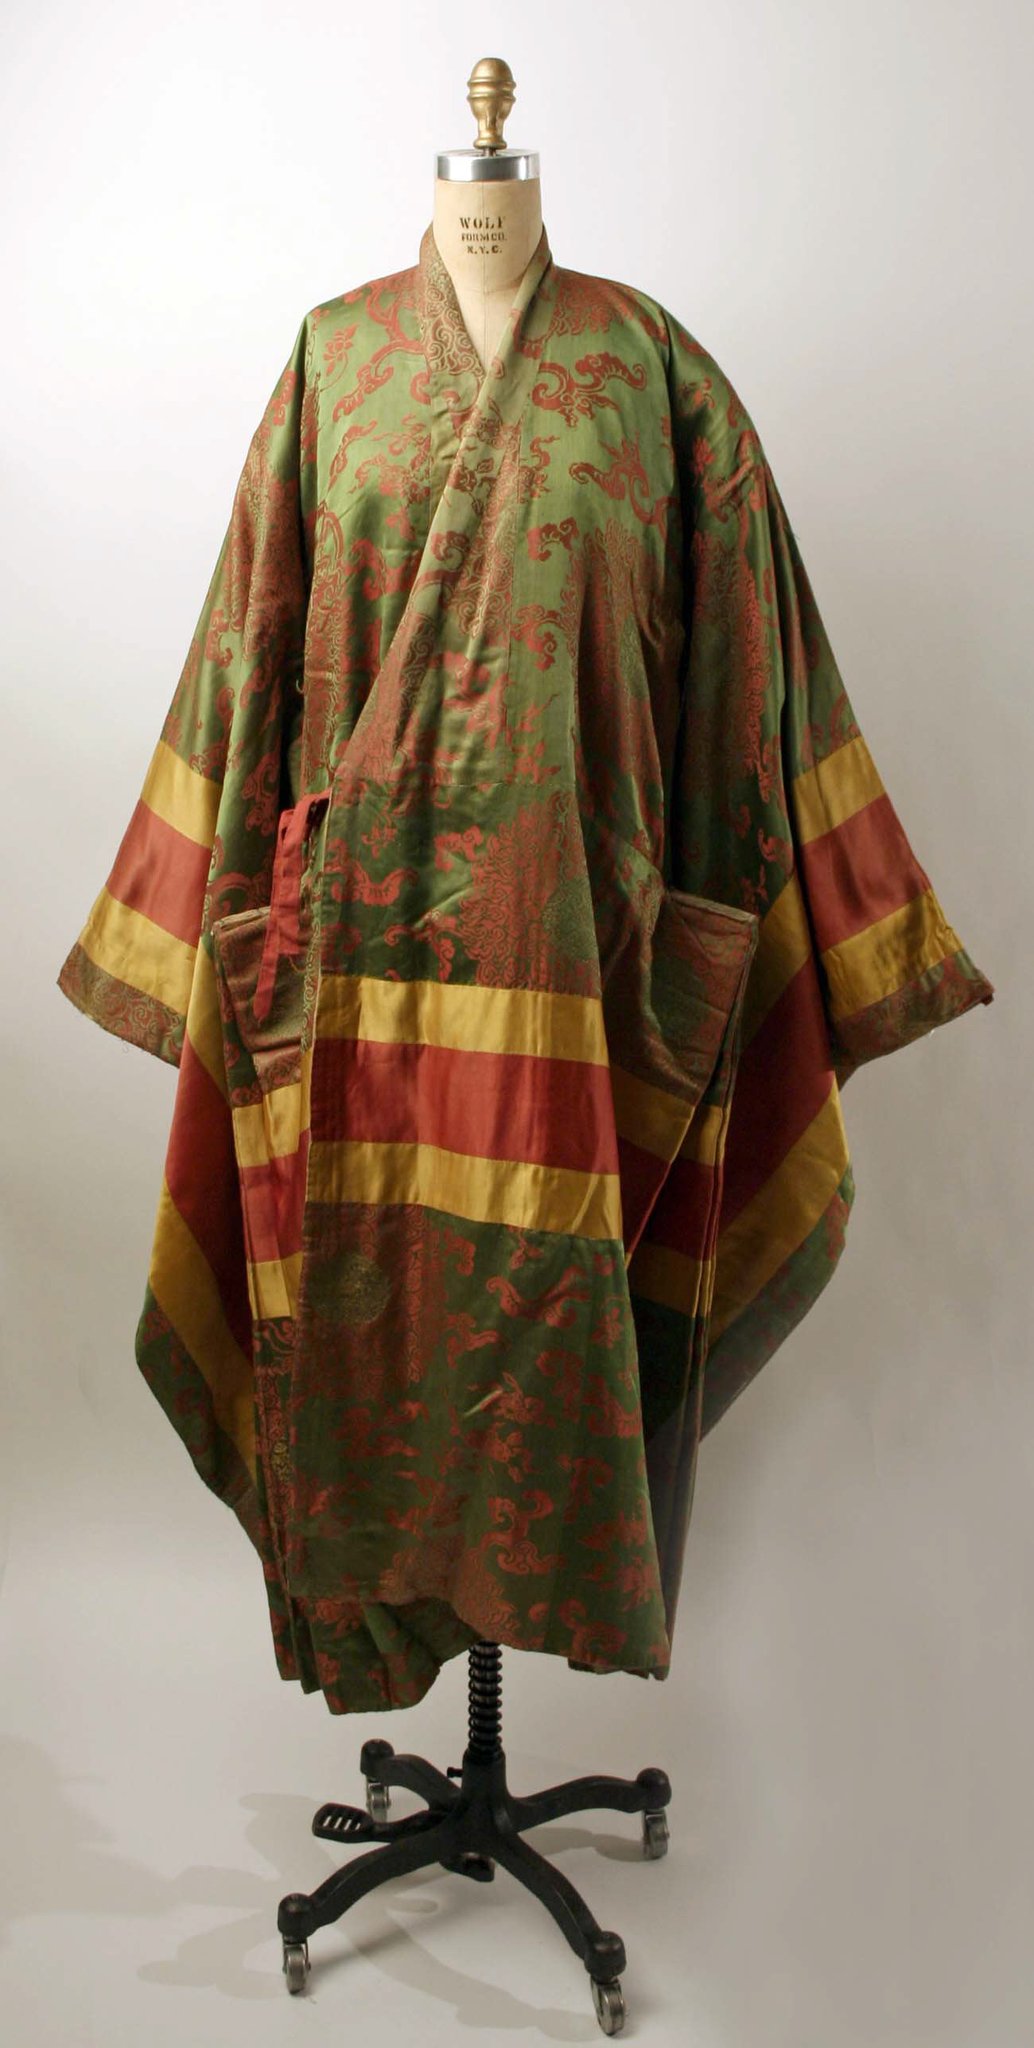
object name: robe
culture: tibetan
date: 1867-1900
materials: fiber, metal, silk